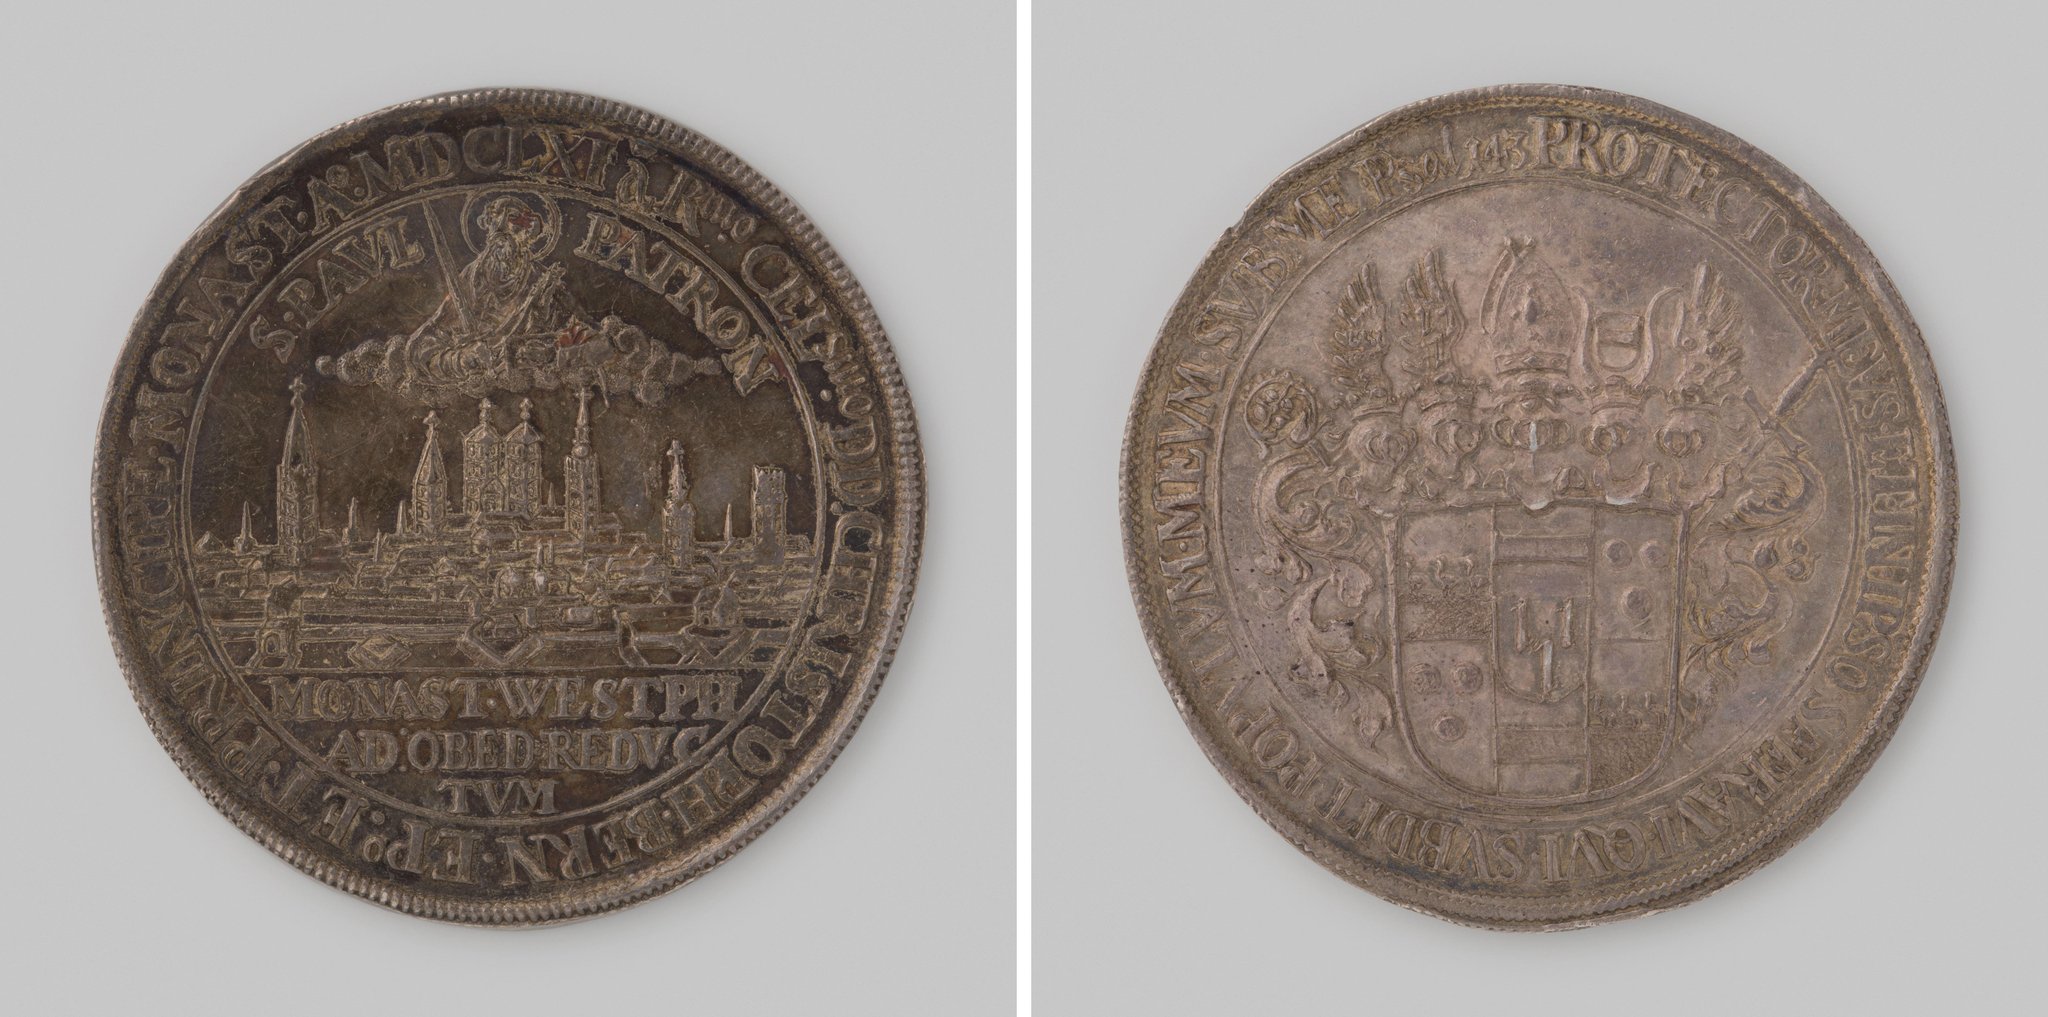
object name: history medal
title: Munster ingenomen door Bernhard van Galen 1661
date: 1661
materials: silver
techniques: striking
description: Zilveren penning, op de voorzijde het aanzicht van Munster waarboven Sint Paulus met zwaard op een wolk, met omschrift en afsnedetekst, op de keerzijde het vijfvoudig gehelmd (de middelste helm gemijterd) zevendelig bisschopelijk wapenschild op kromstaf en zwaard, met omschrift.